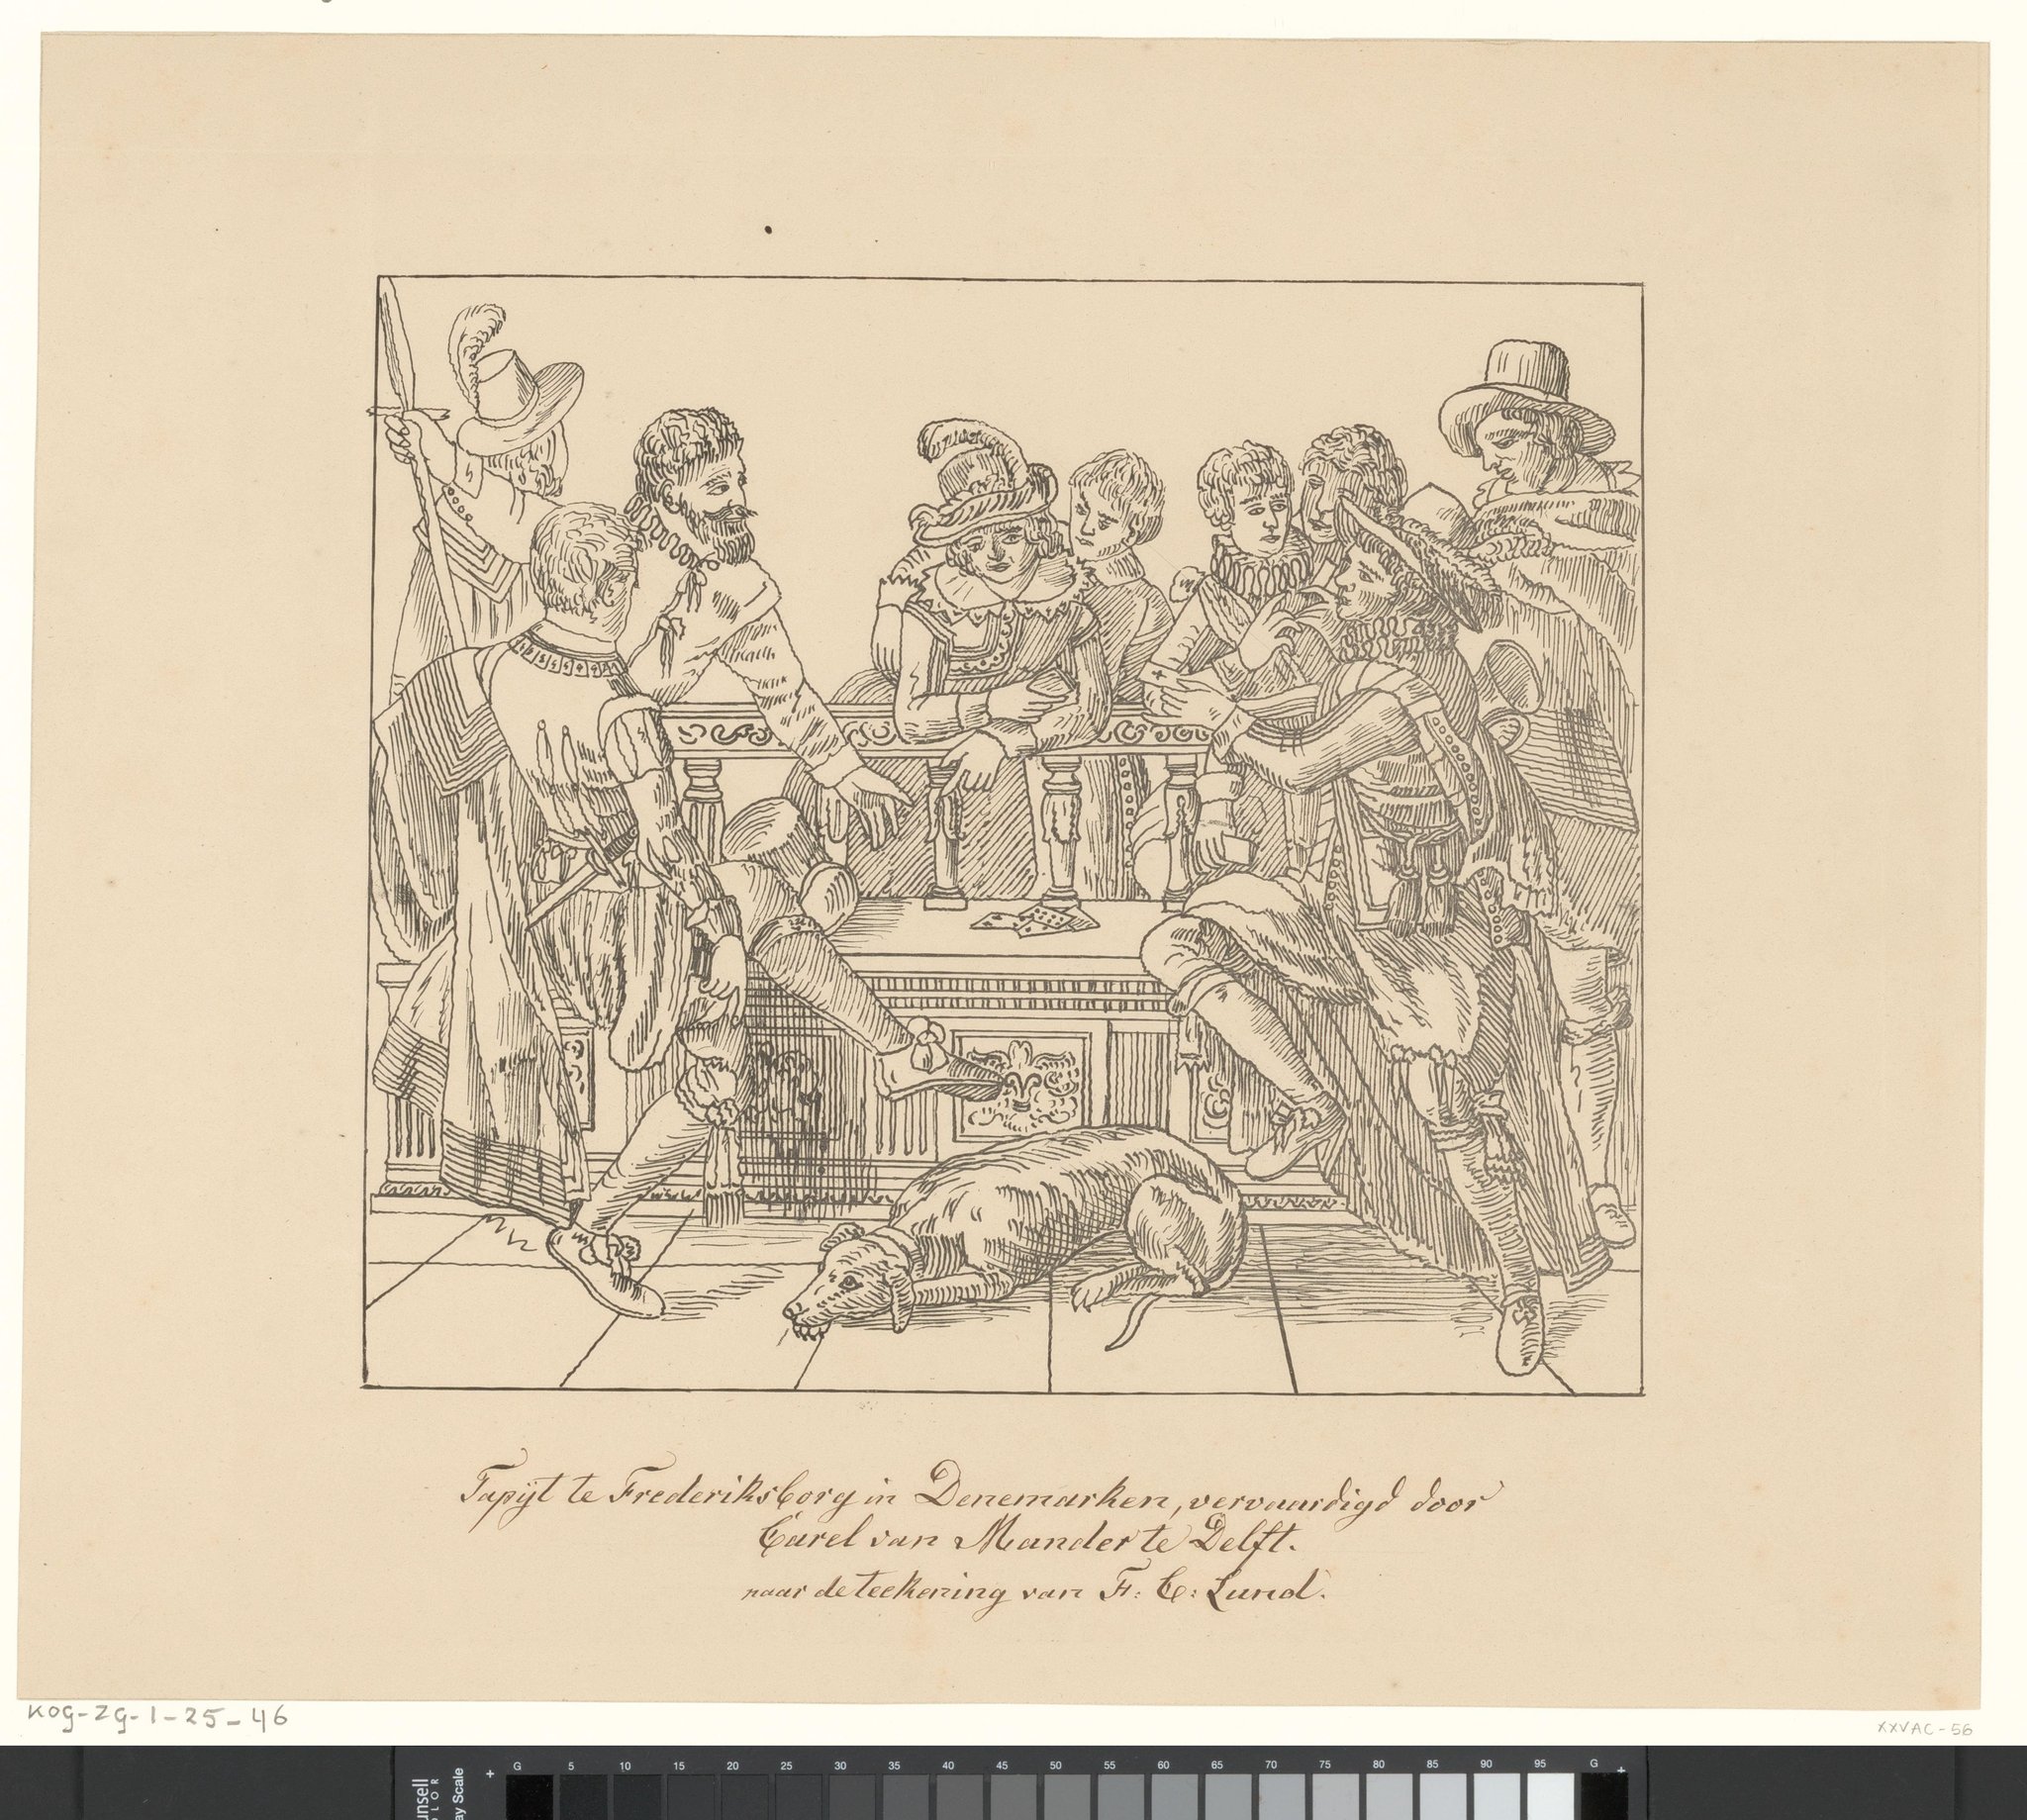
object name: print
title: Kaartspelend gezelschap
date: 1870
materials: paper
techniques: lithograph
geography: delft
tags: playing-cards, dog, delft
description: Naar een tapijt uit Frederiksborg. Onderwerpsrubrieken binnen de Atlas Zeden en Gewoonten: Zeden en Gewoonten in Engeren Zin, De Woning, Binnenhuizen, Wandversiering.